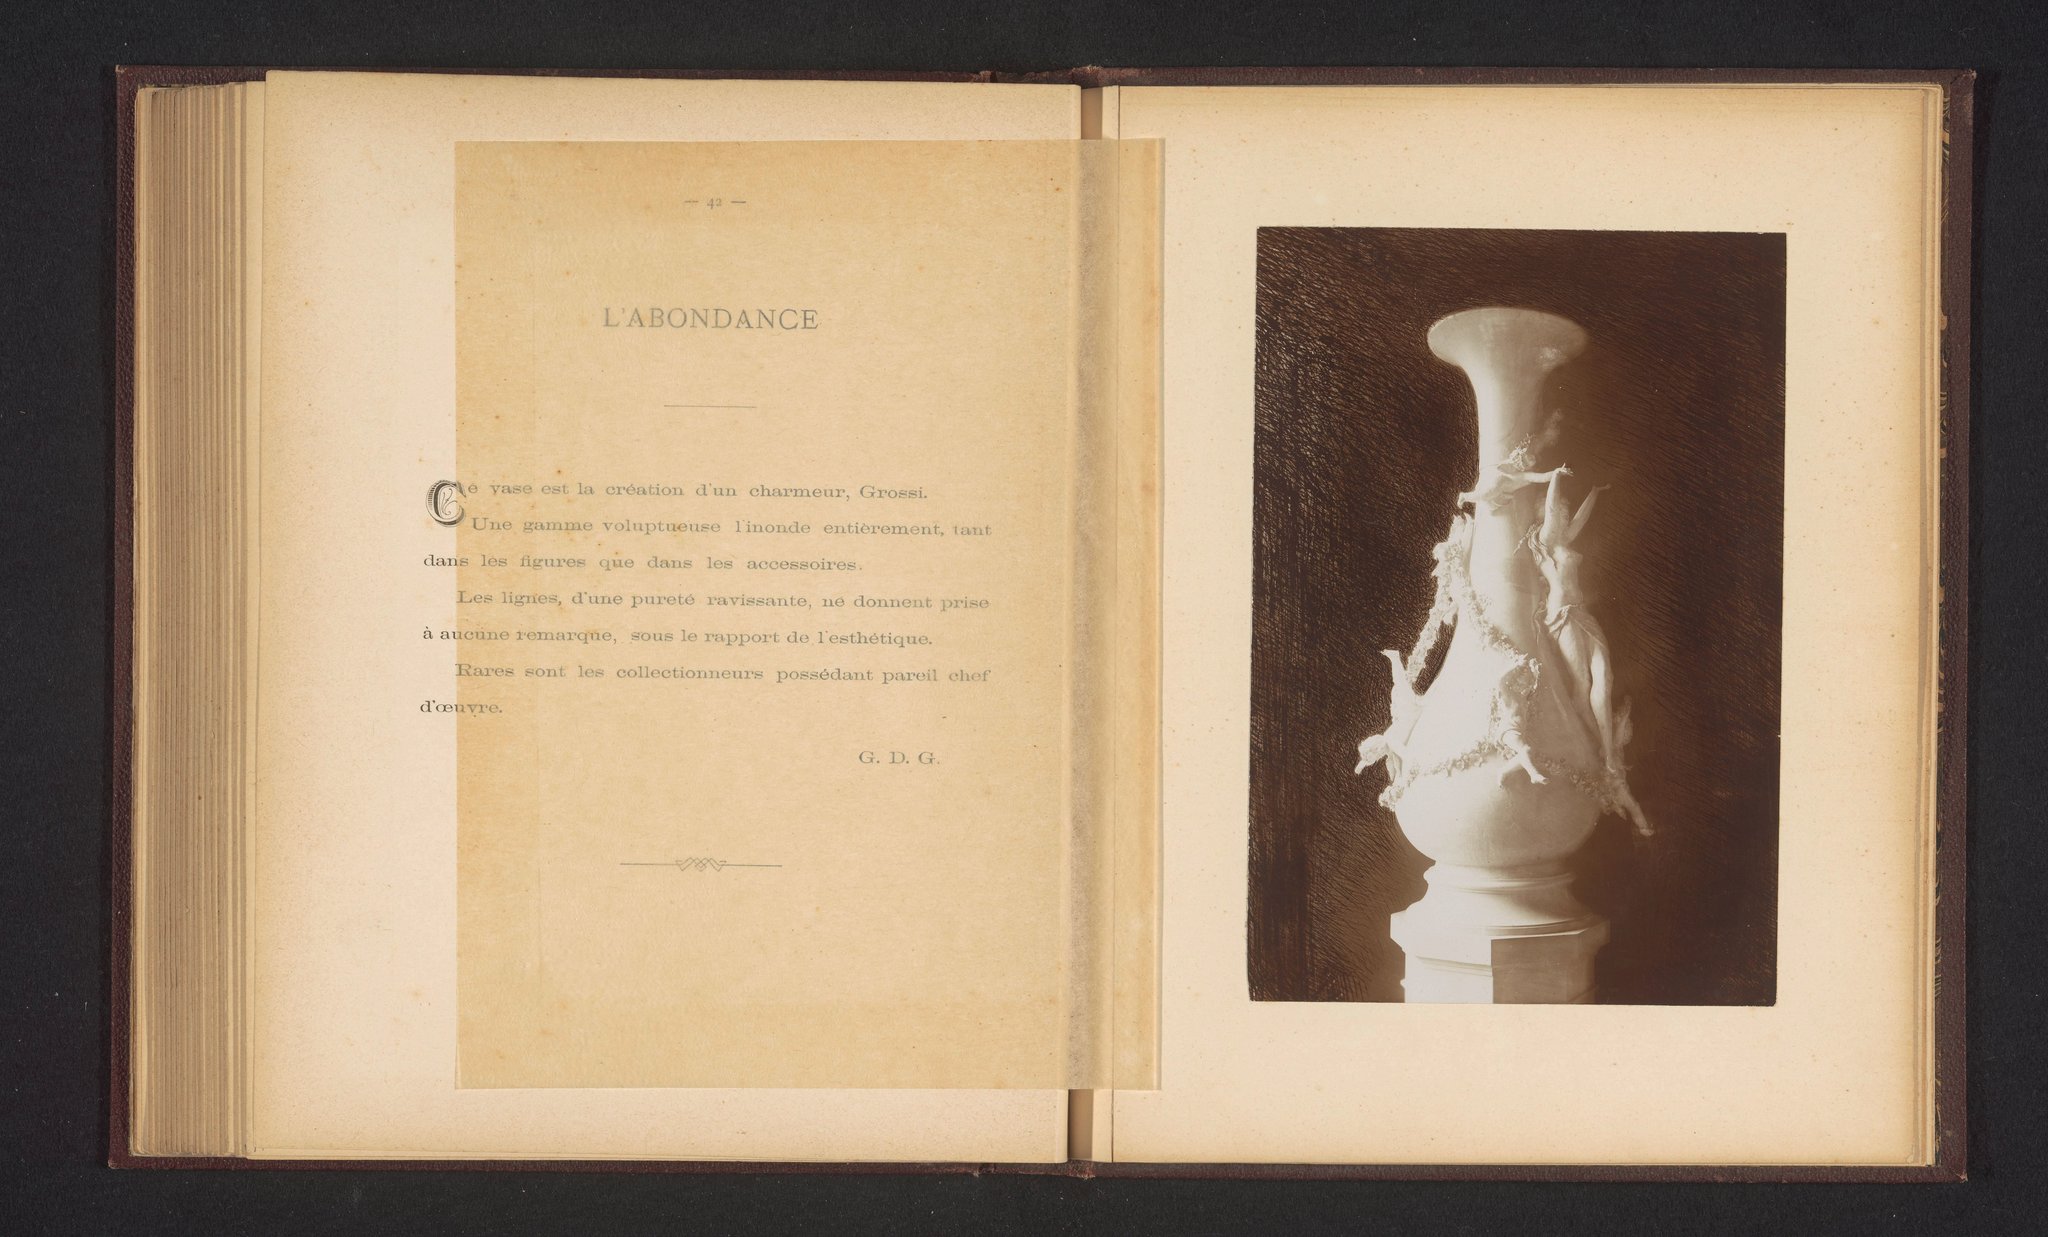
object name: page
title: Vaas, waarop afgebeeld een allegorie op de overvloed, door Grossi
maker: alexandre van antro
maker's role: painter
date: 1891-1896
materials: photographic support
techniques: collodion silver print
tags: vase ~ ornament, abundance; 'abondanza', 'abondanza maritima' (ripa), piece of sculpture, reproduction of a piece of sculpture